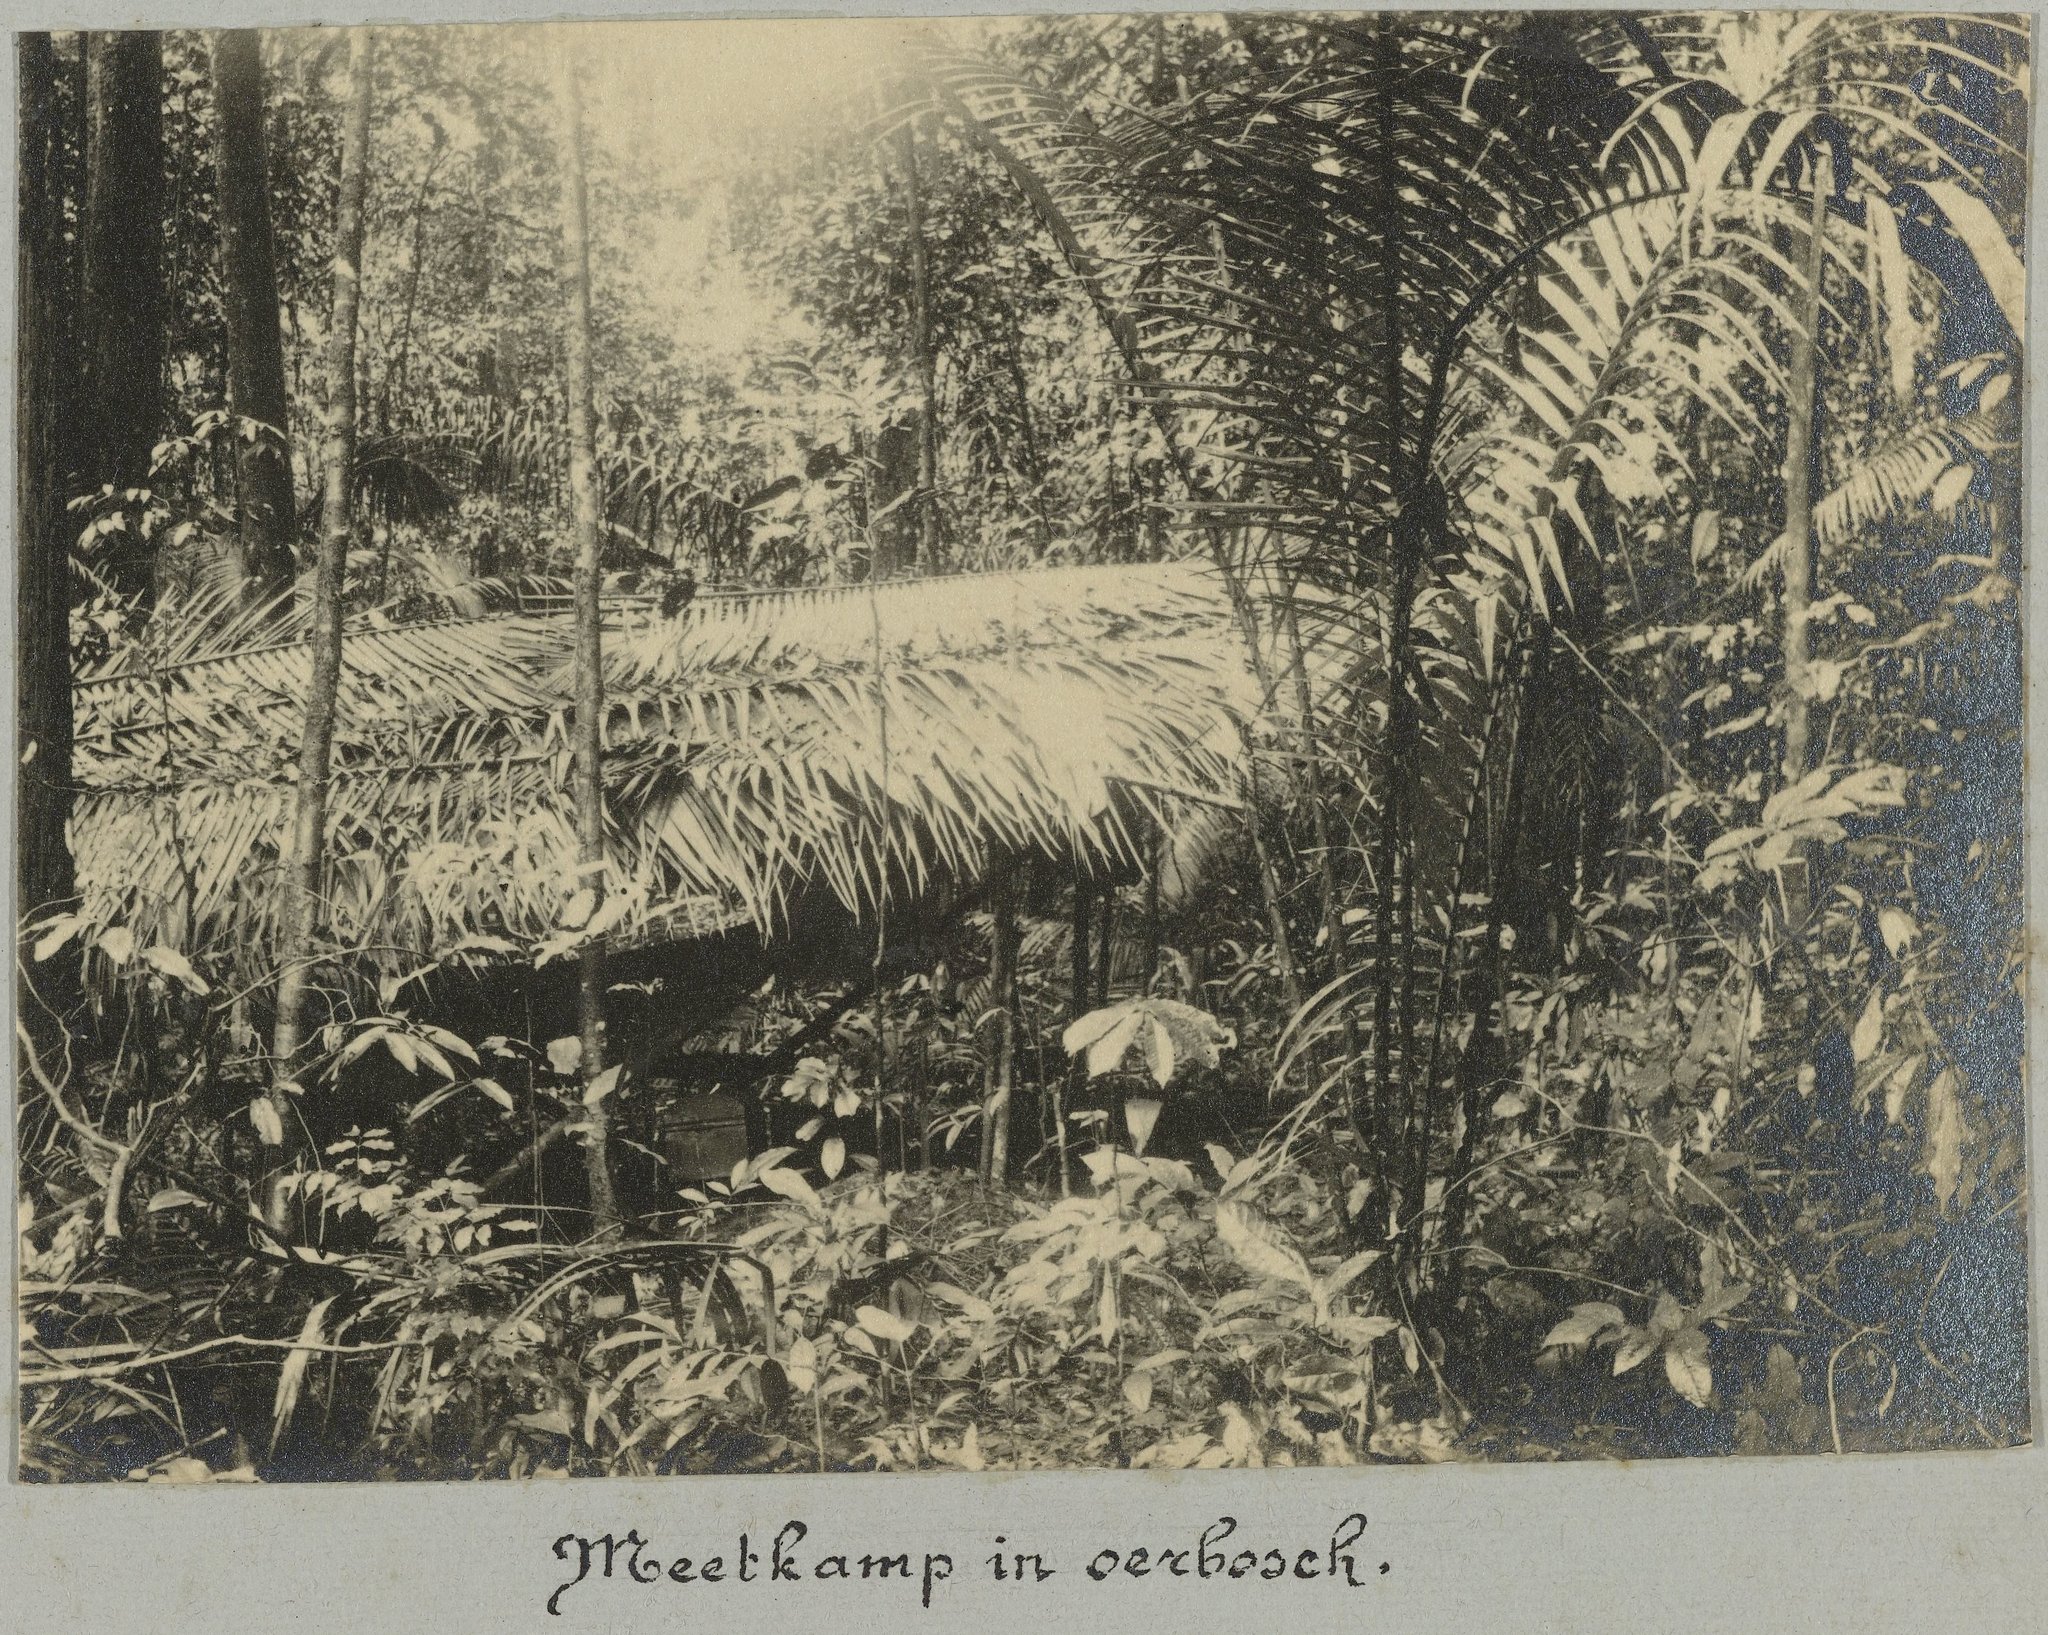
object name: photograph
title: Meetkamp in oerbosch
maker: hendrik doijer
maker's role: engineer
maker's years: 1863-1925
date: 1903-1910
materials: photographic support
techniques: gelatin silver print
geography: suriname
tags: suriname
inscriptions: inscription: ‘8. / Meetkamp in oerbosch’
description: Gezicht op een hut gebouwd van takken en bladeren in het meetkamp, in het oerwoud. Onderdeel van het fotoalbum Souvenir de Voyage (deel 1), over het leven van de familie Doijer in en rond de plantage Ma Retraite in Suriname in de jaren 1903-1910.